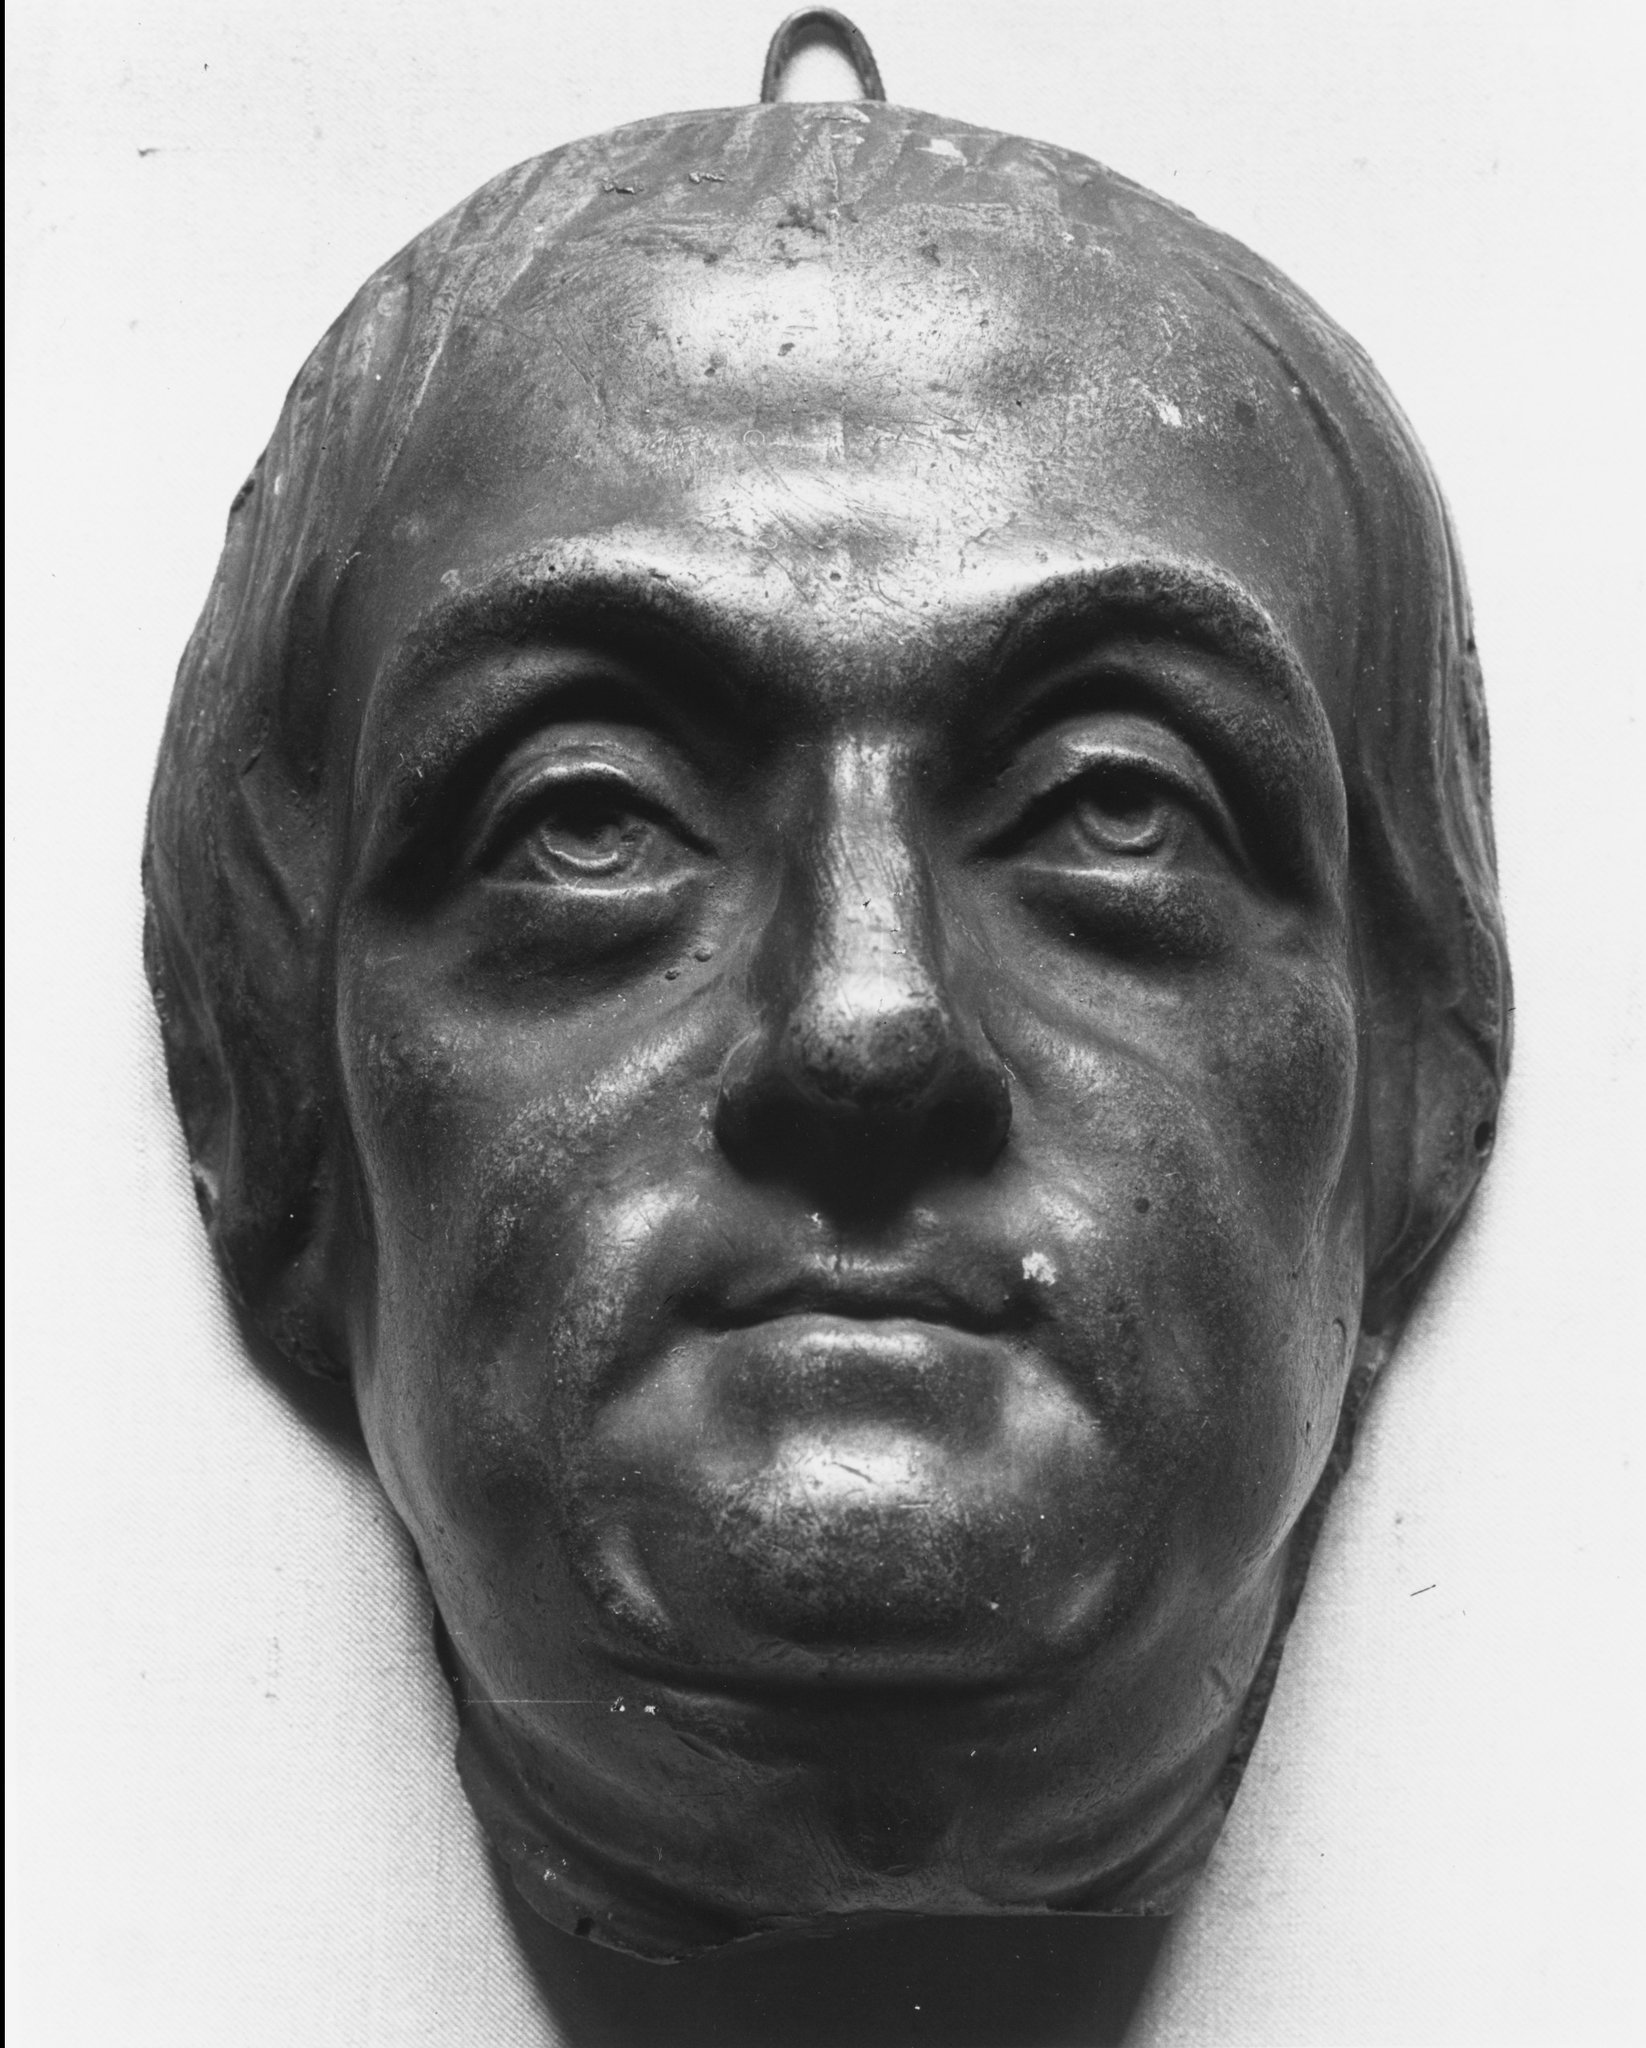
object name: mask cast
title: Mask Cast of Benjamin Franklin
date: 1800-1883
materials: plaster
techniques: painting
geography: france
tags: masks,benjamin franklin,faces